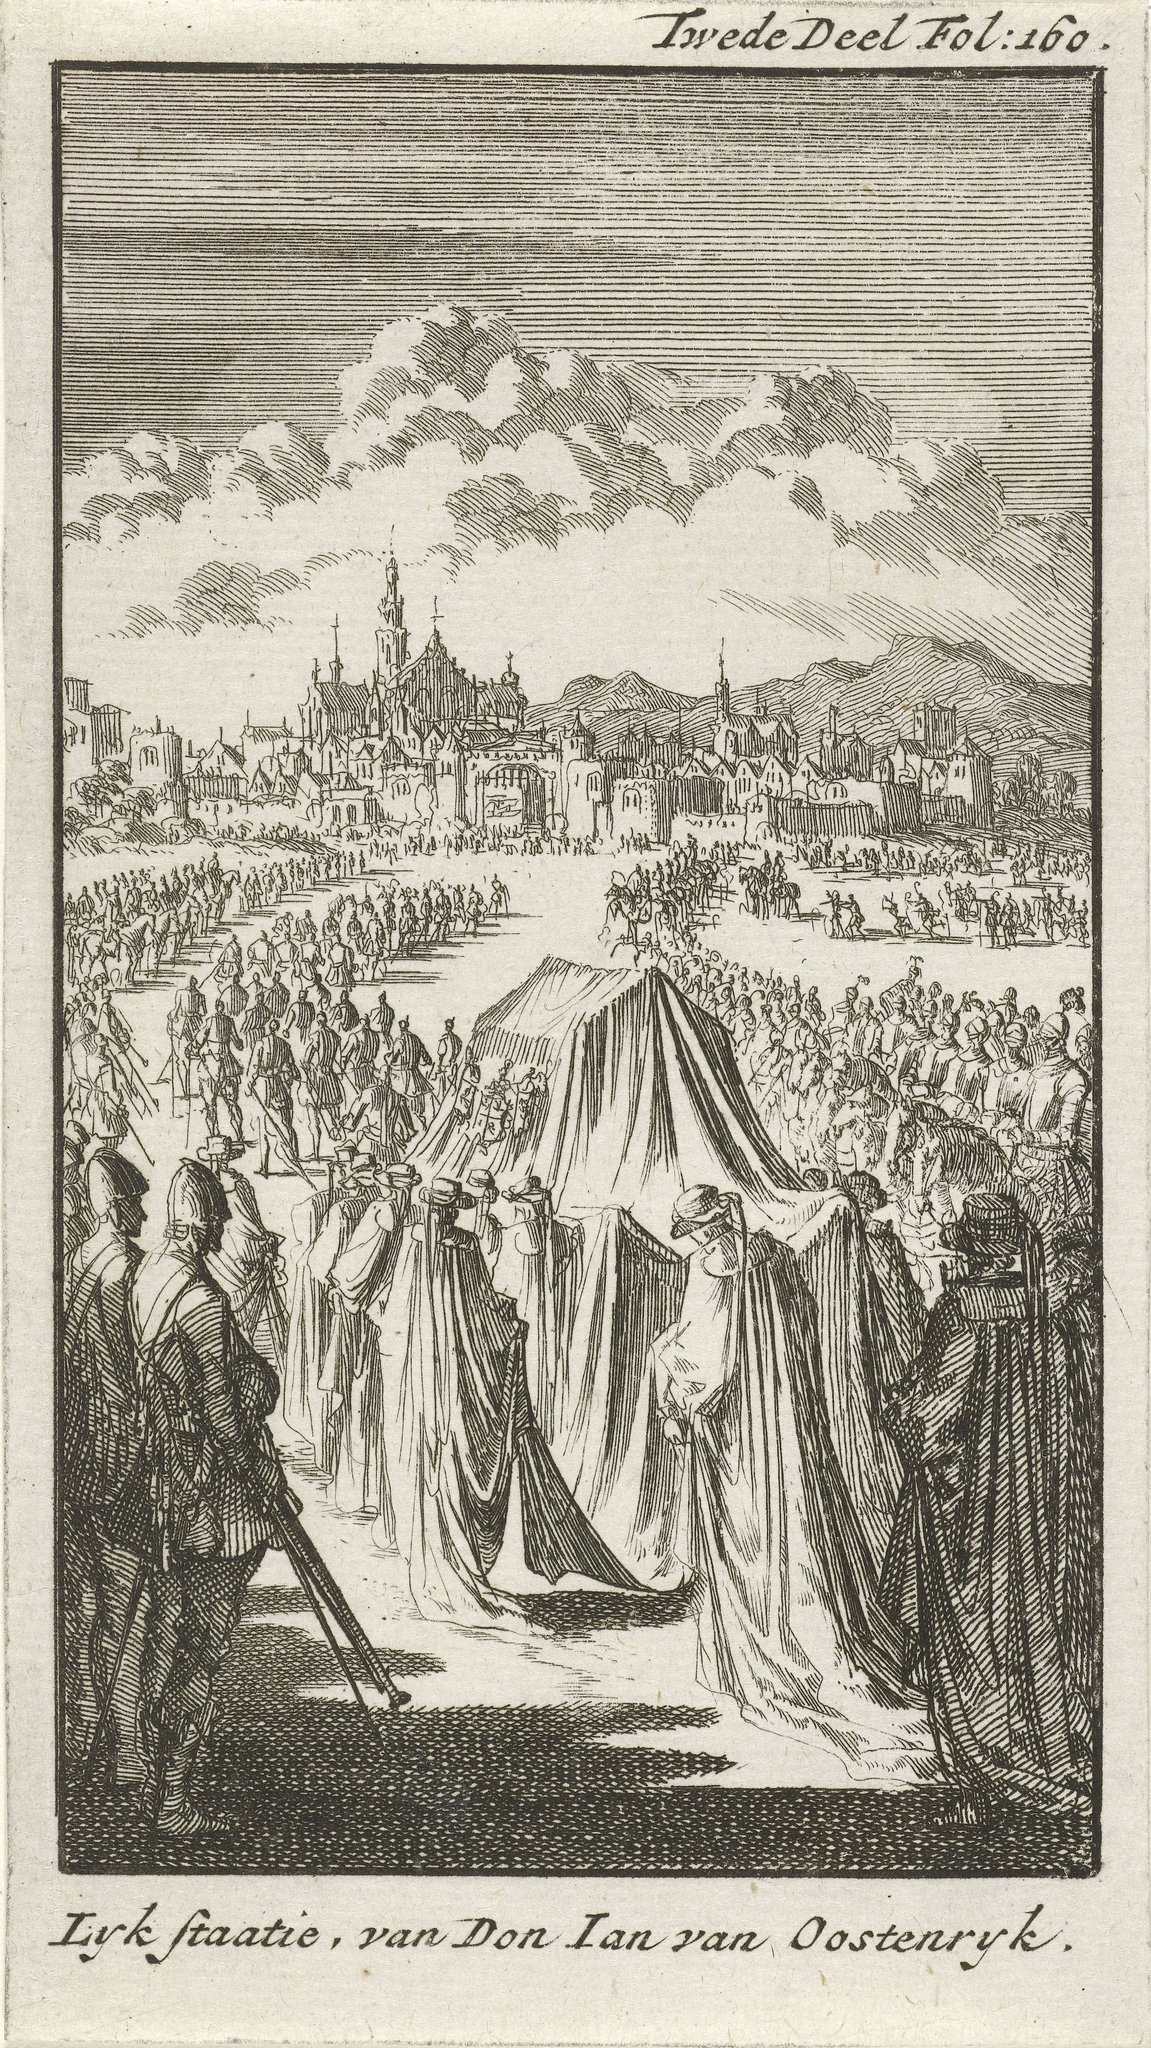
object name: history print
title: Lyk staatie, van Don Ian van Oostenryk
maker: jan luyken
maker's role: draughtsman, print maker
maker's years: 1649-1712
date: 1697-1699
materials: paper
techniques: etching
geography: northern netherlands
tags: don juan van oostenrijk, cortege, funeral procession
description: Gebruikt als illustratie in: G. Leti, Het leven van Filips de II, koning van Spanien, E. Boucquet, 's-Gravenhage 1699, 2 delen, dl. 2, fol. 160.